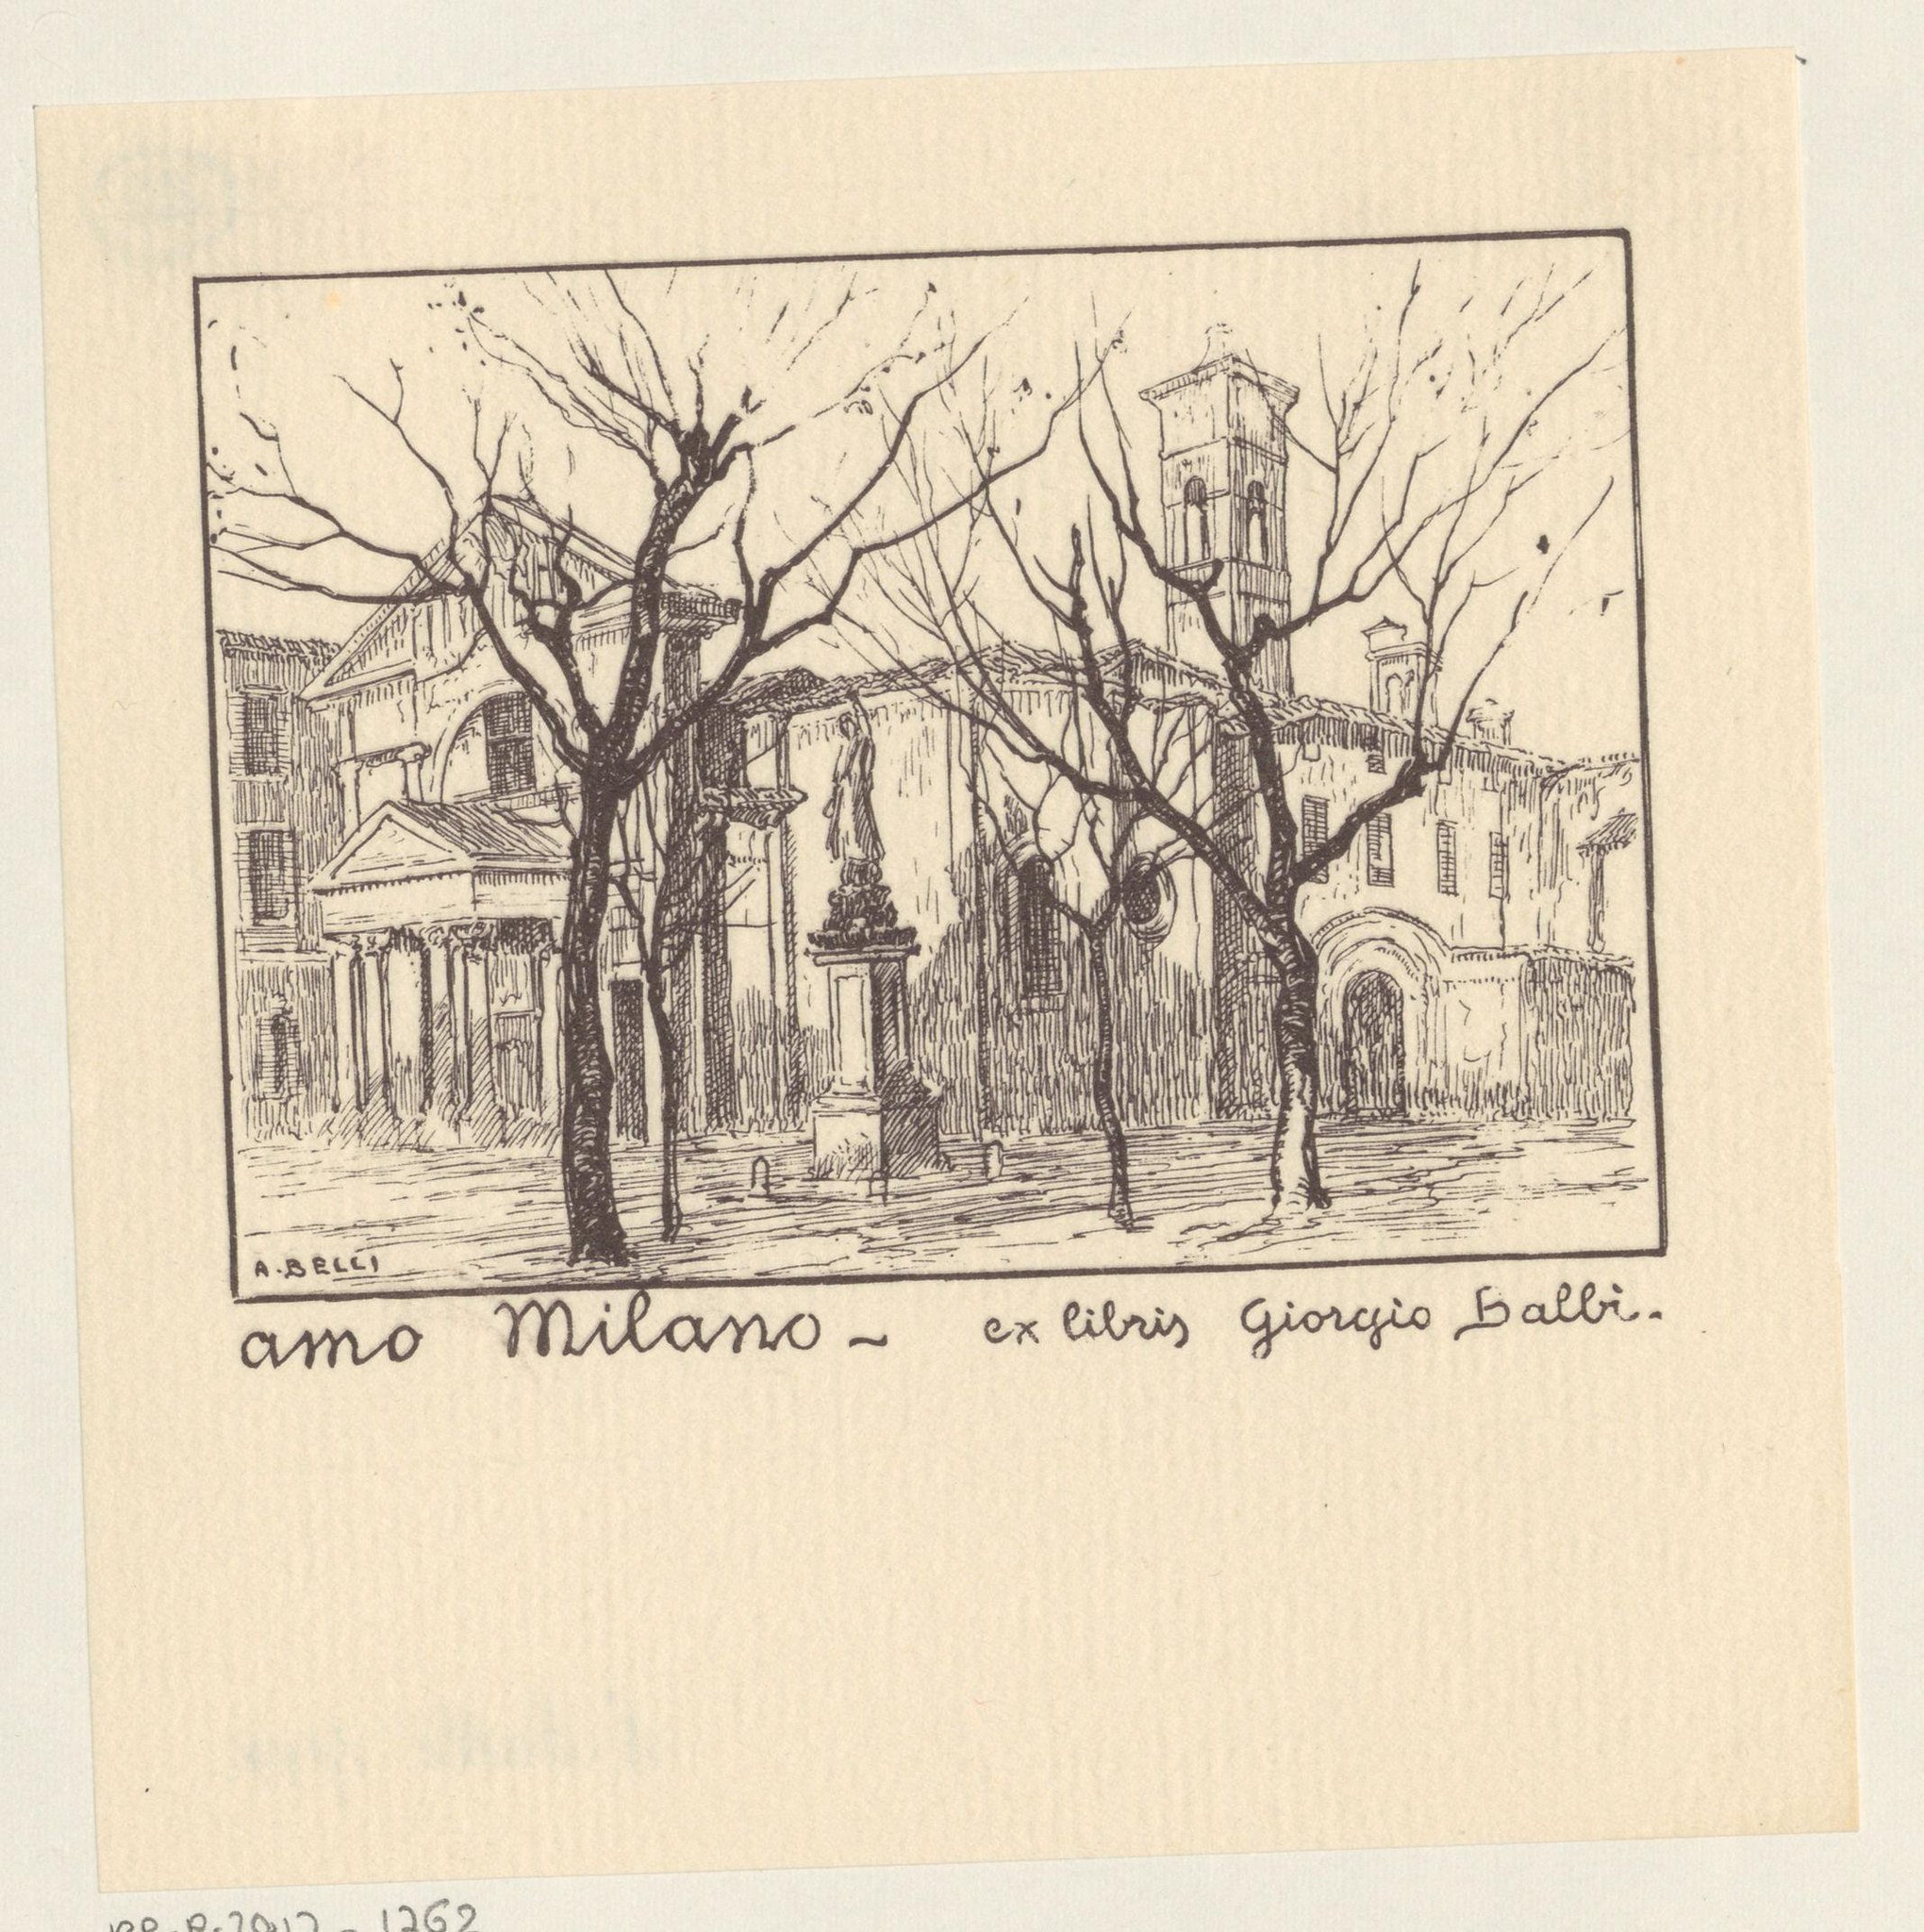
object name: bookplate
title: Ex libris van Giorgio Balbi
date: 1944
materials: paper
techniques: printing block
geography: italy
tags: parts of church exterior and annexes: campanile, trees, roman catholic church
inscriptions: inscription: ‘A. Belli 1944’